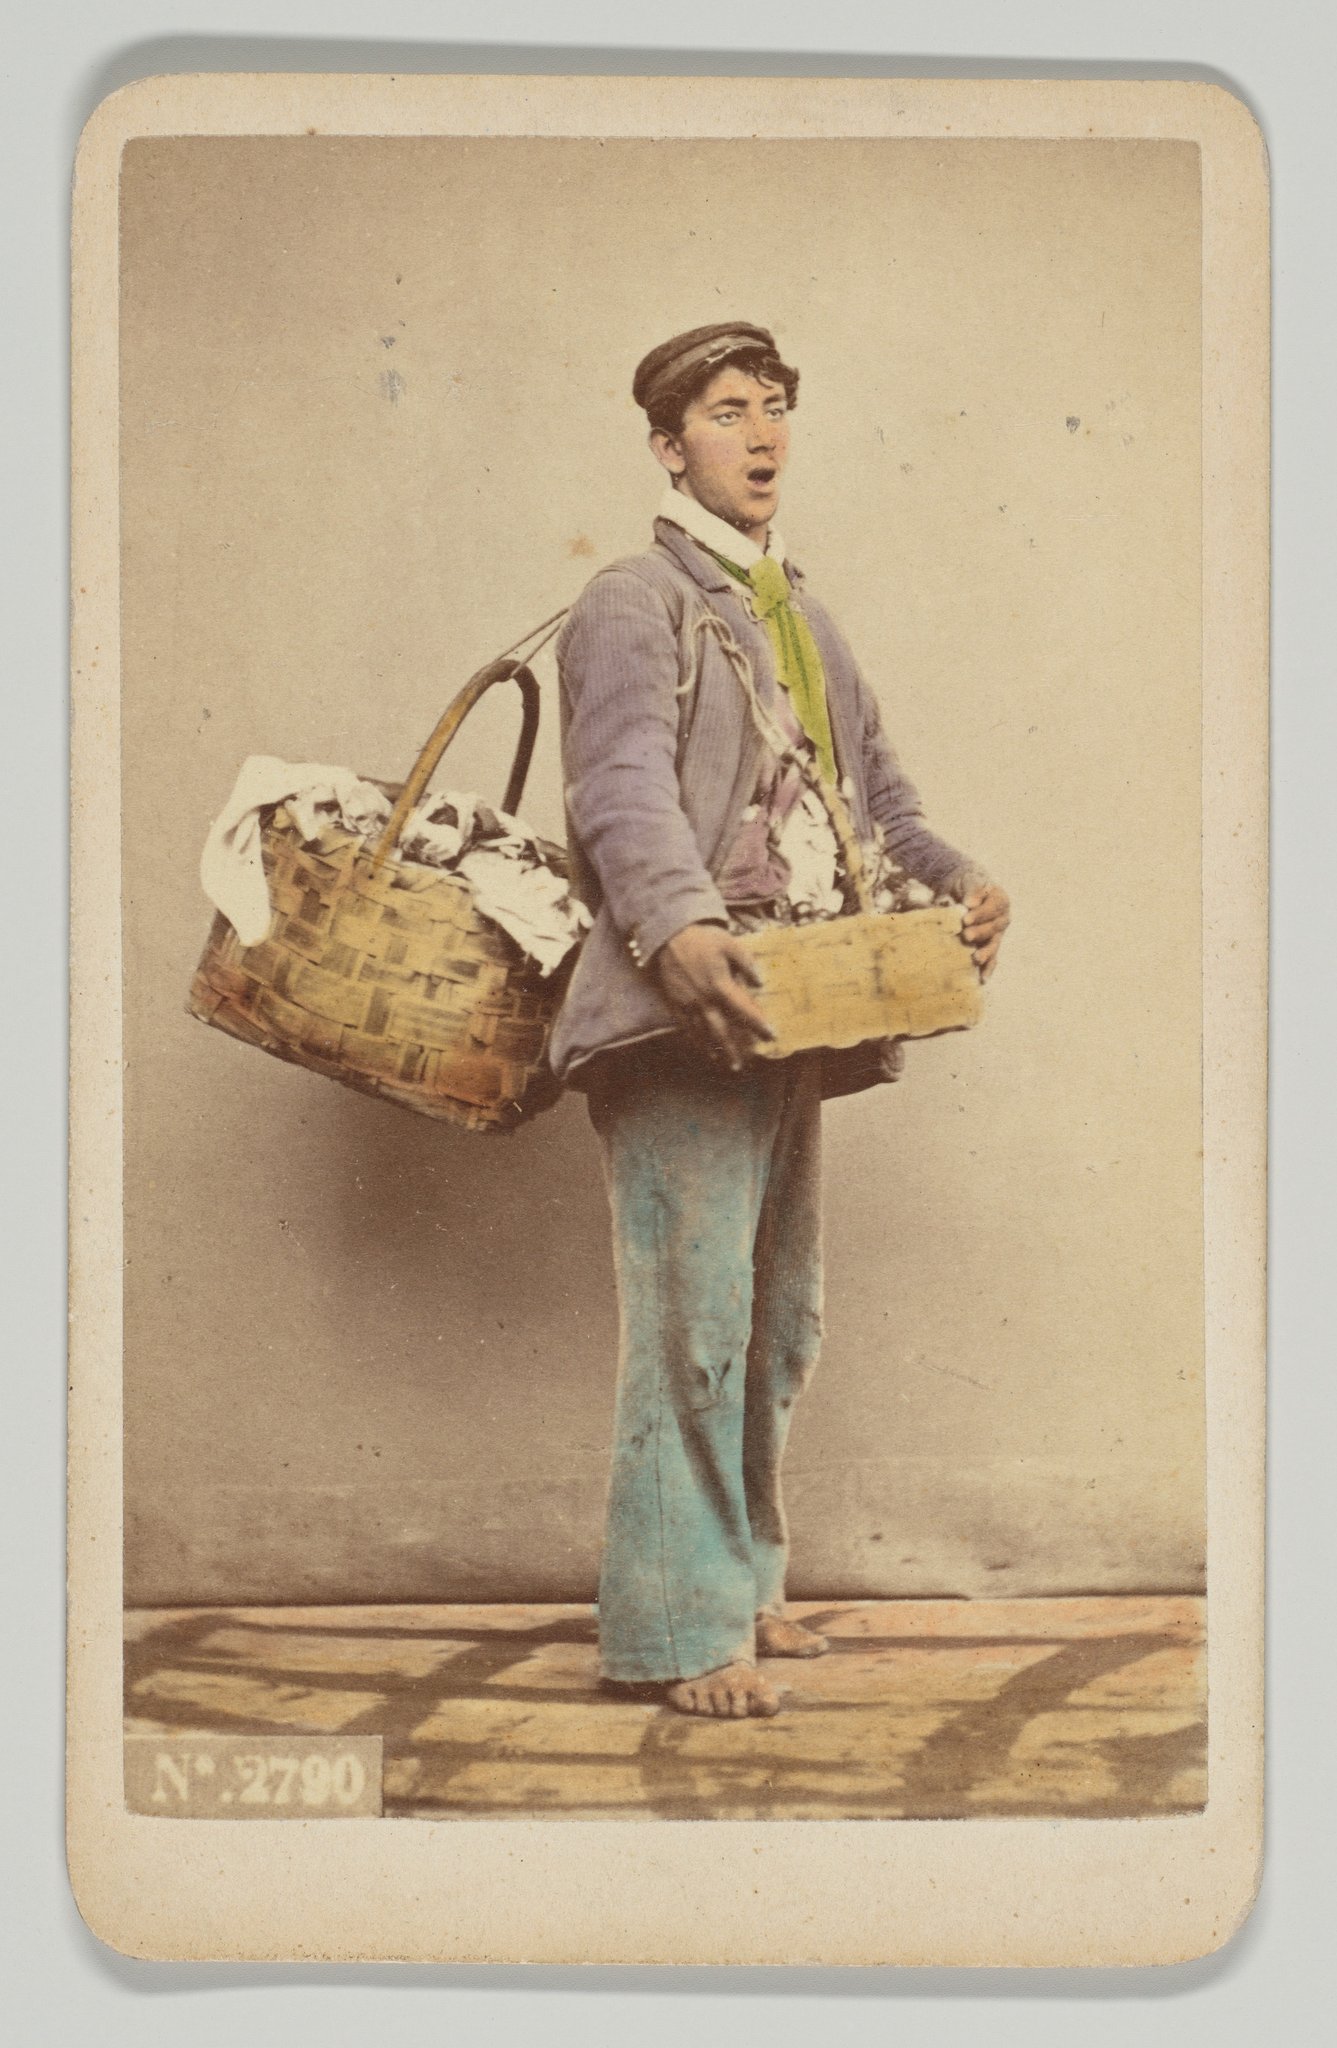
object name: carte de visite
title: [Neapolitan Folk Scene]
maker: giorgio sommer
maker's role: fotograaf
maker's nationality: italian, born germany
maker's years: 1834-1914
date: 1867-1873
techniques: albumen silver print